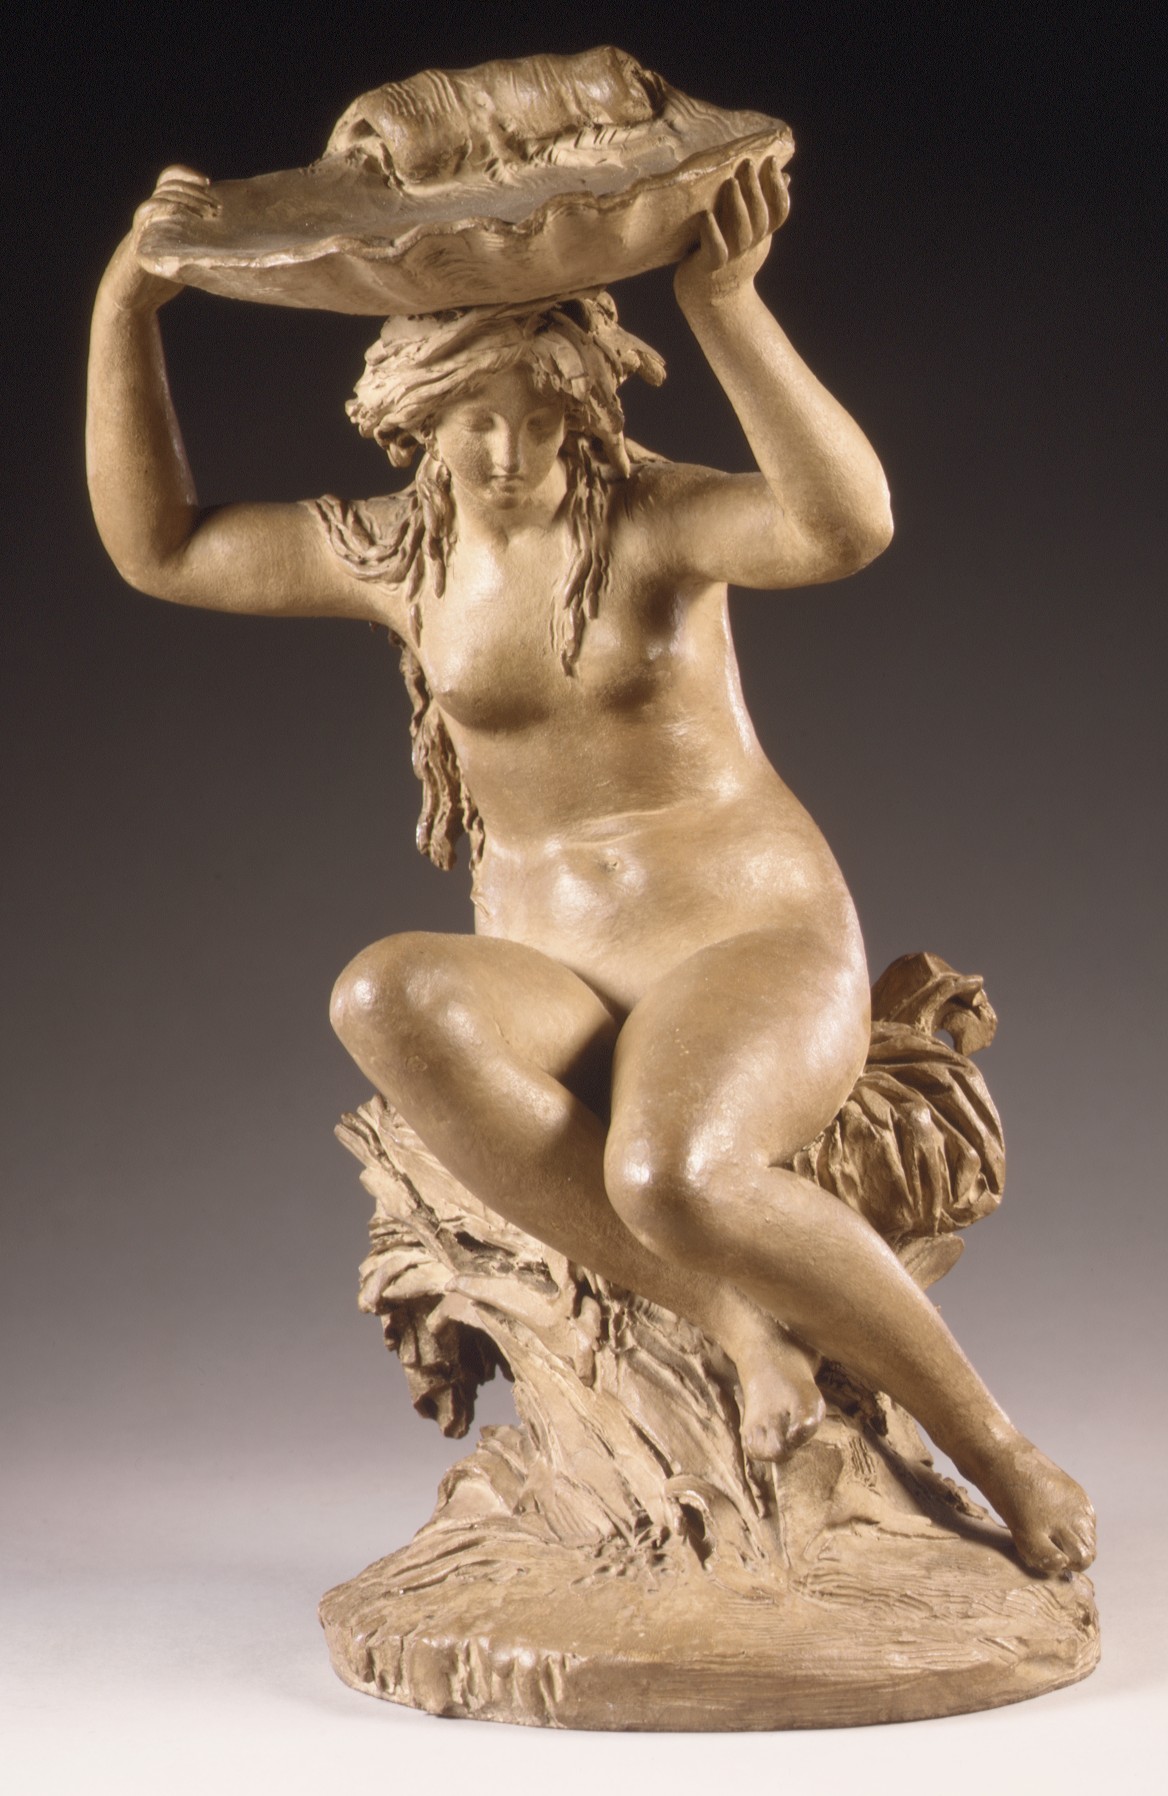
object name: statuette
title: Naiad Supporting a Shell on her Head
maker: joseph-charles marin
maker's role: artist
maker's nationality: french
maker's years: 1759-1834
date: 1793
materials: terracotta, varnish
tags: female nudes,nymphs,shells